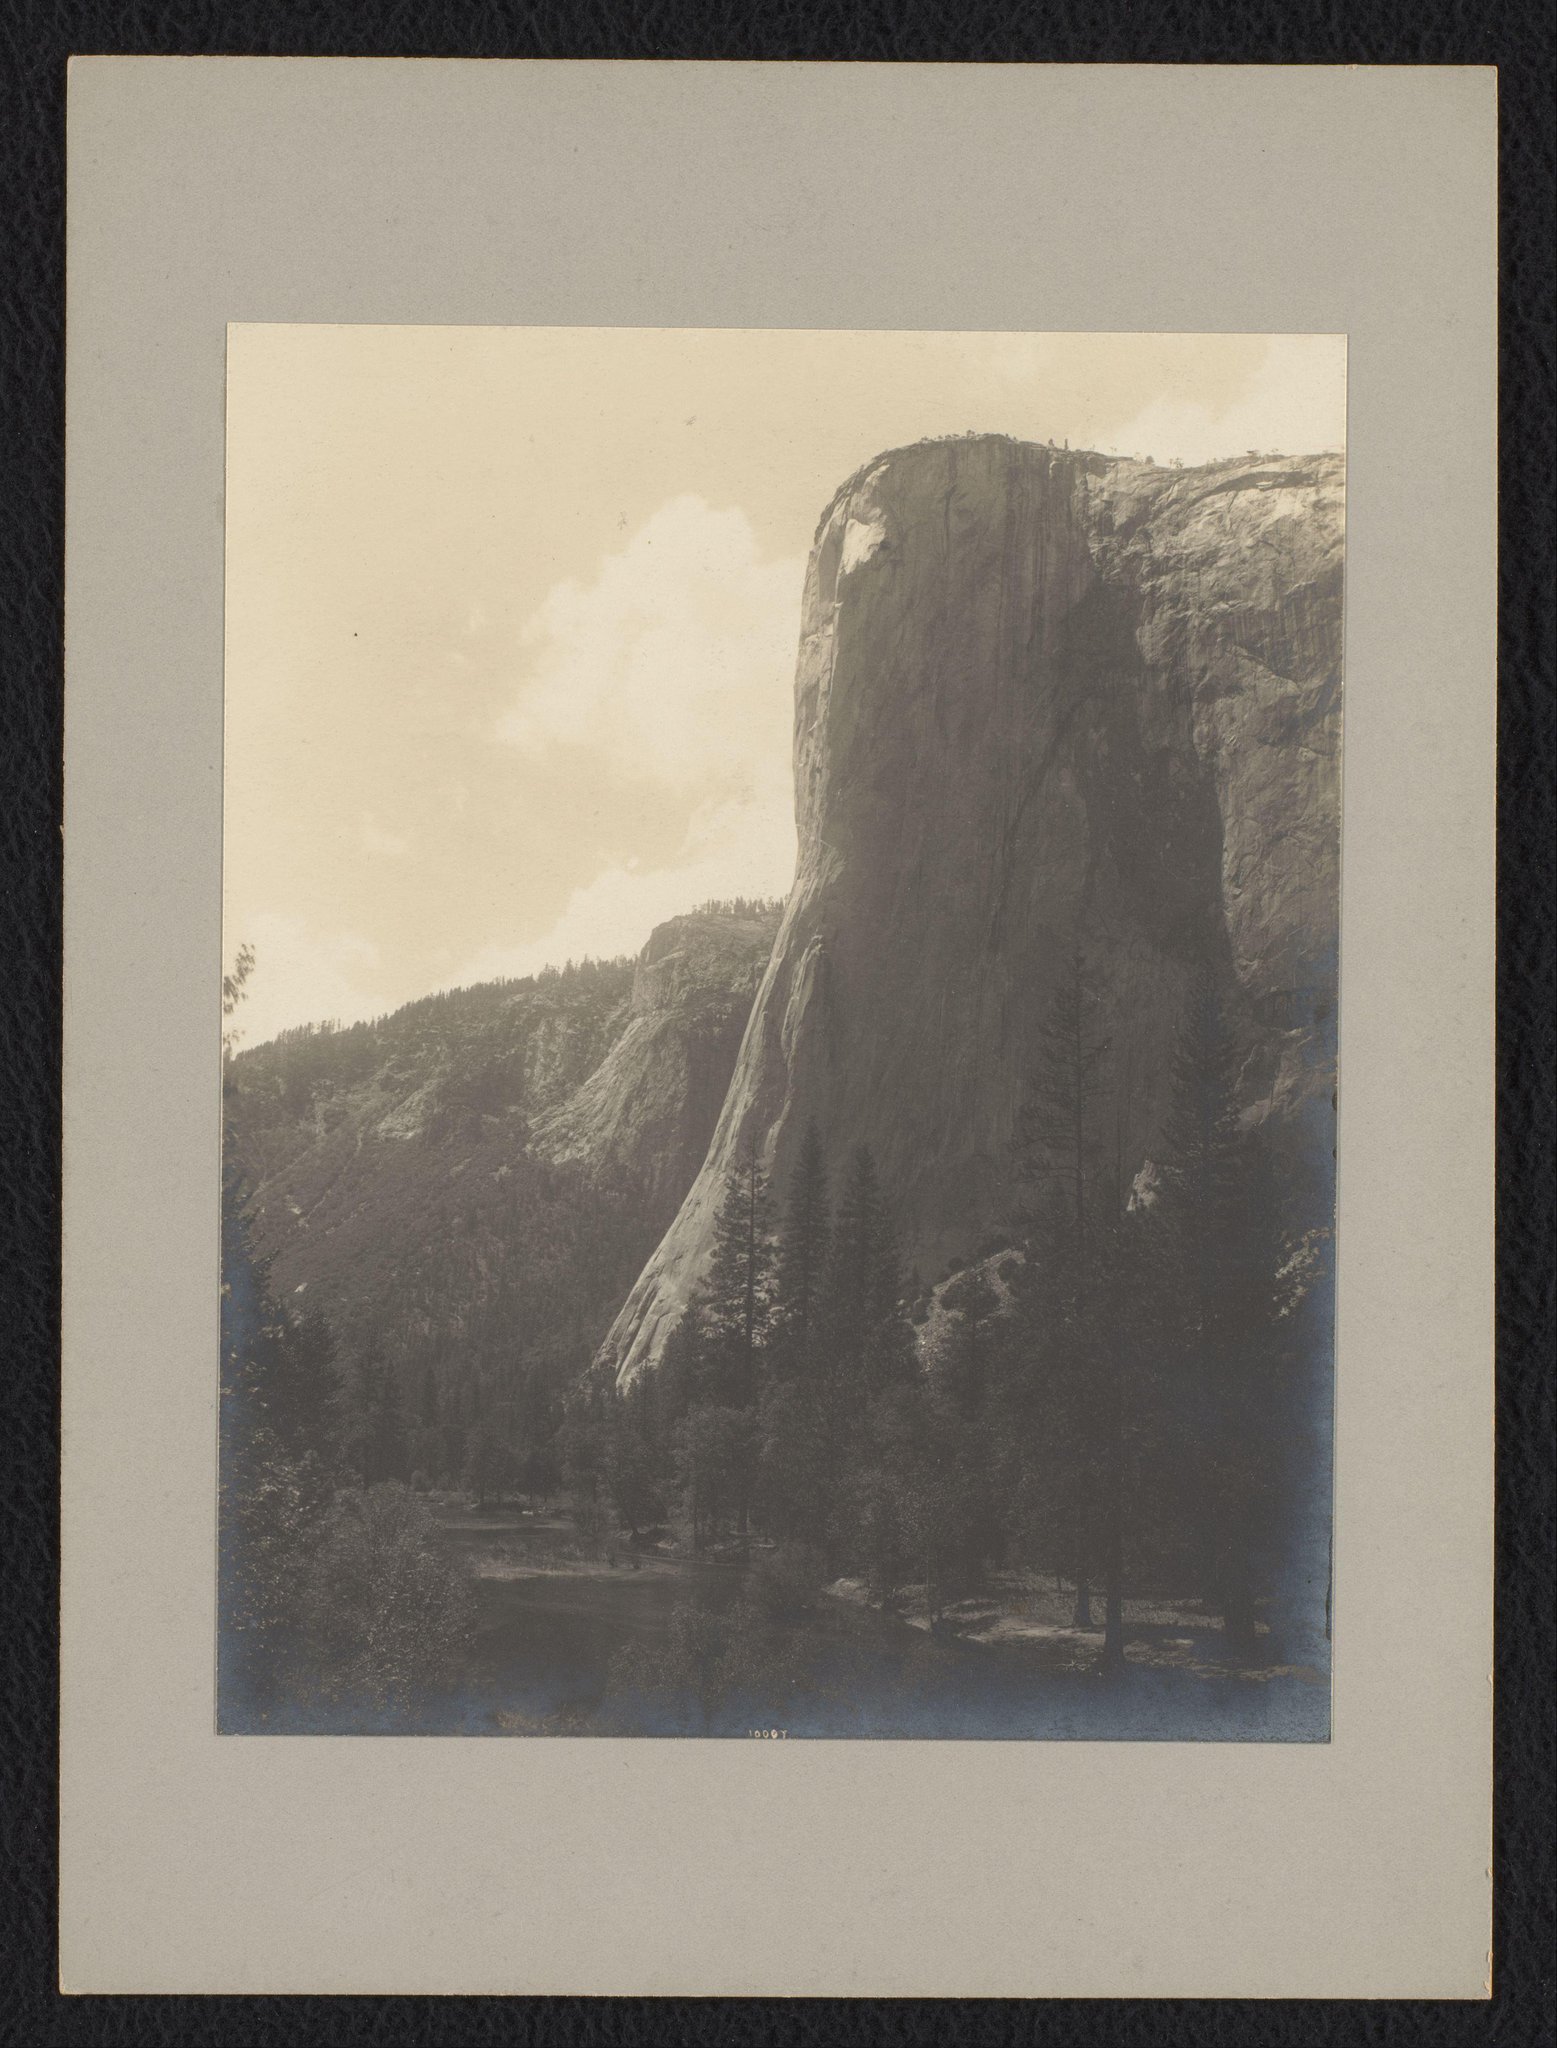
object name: photograph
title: Yosemite Vallei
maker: Anonymous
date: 1895-1915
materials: cardboard, photographic support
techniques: gelatin silver print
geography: california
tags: californië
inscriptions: annotation: ‘1. Yosemete-Valley, Californië’